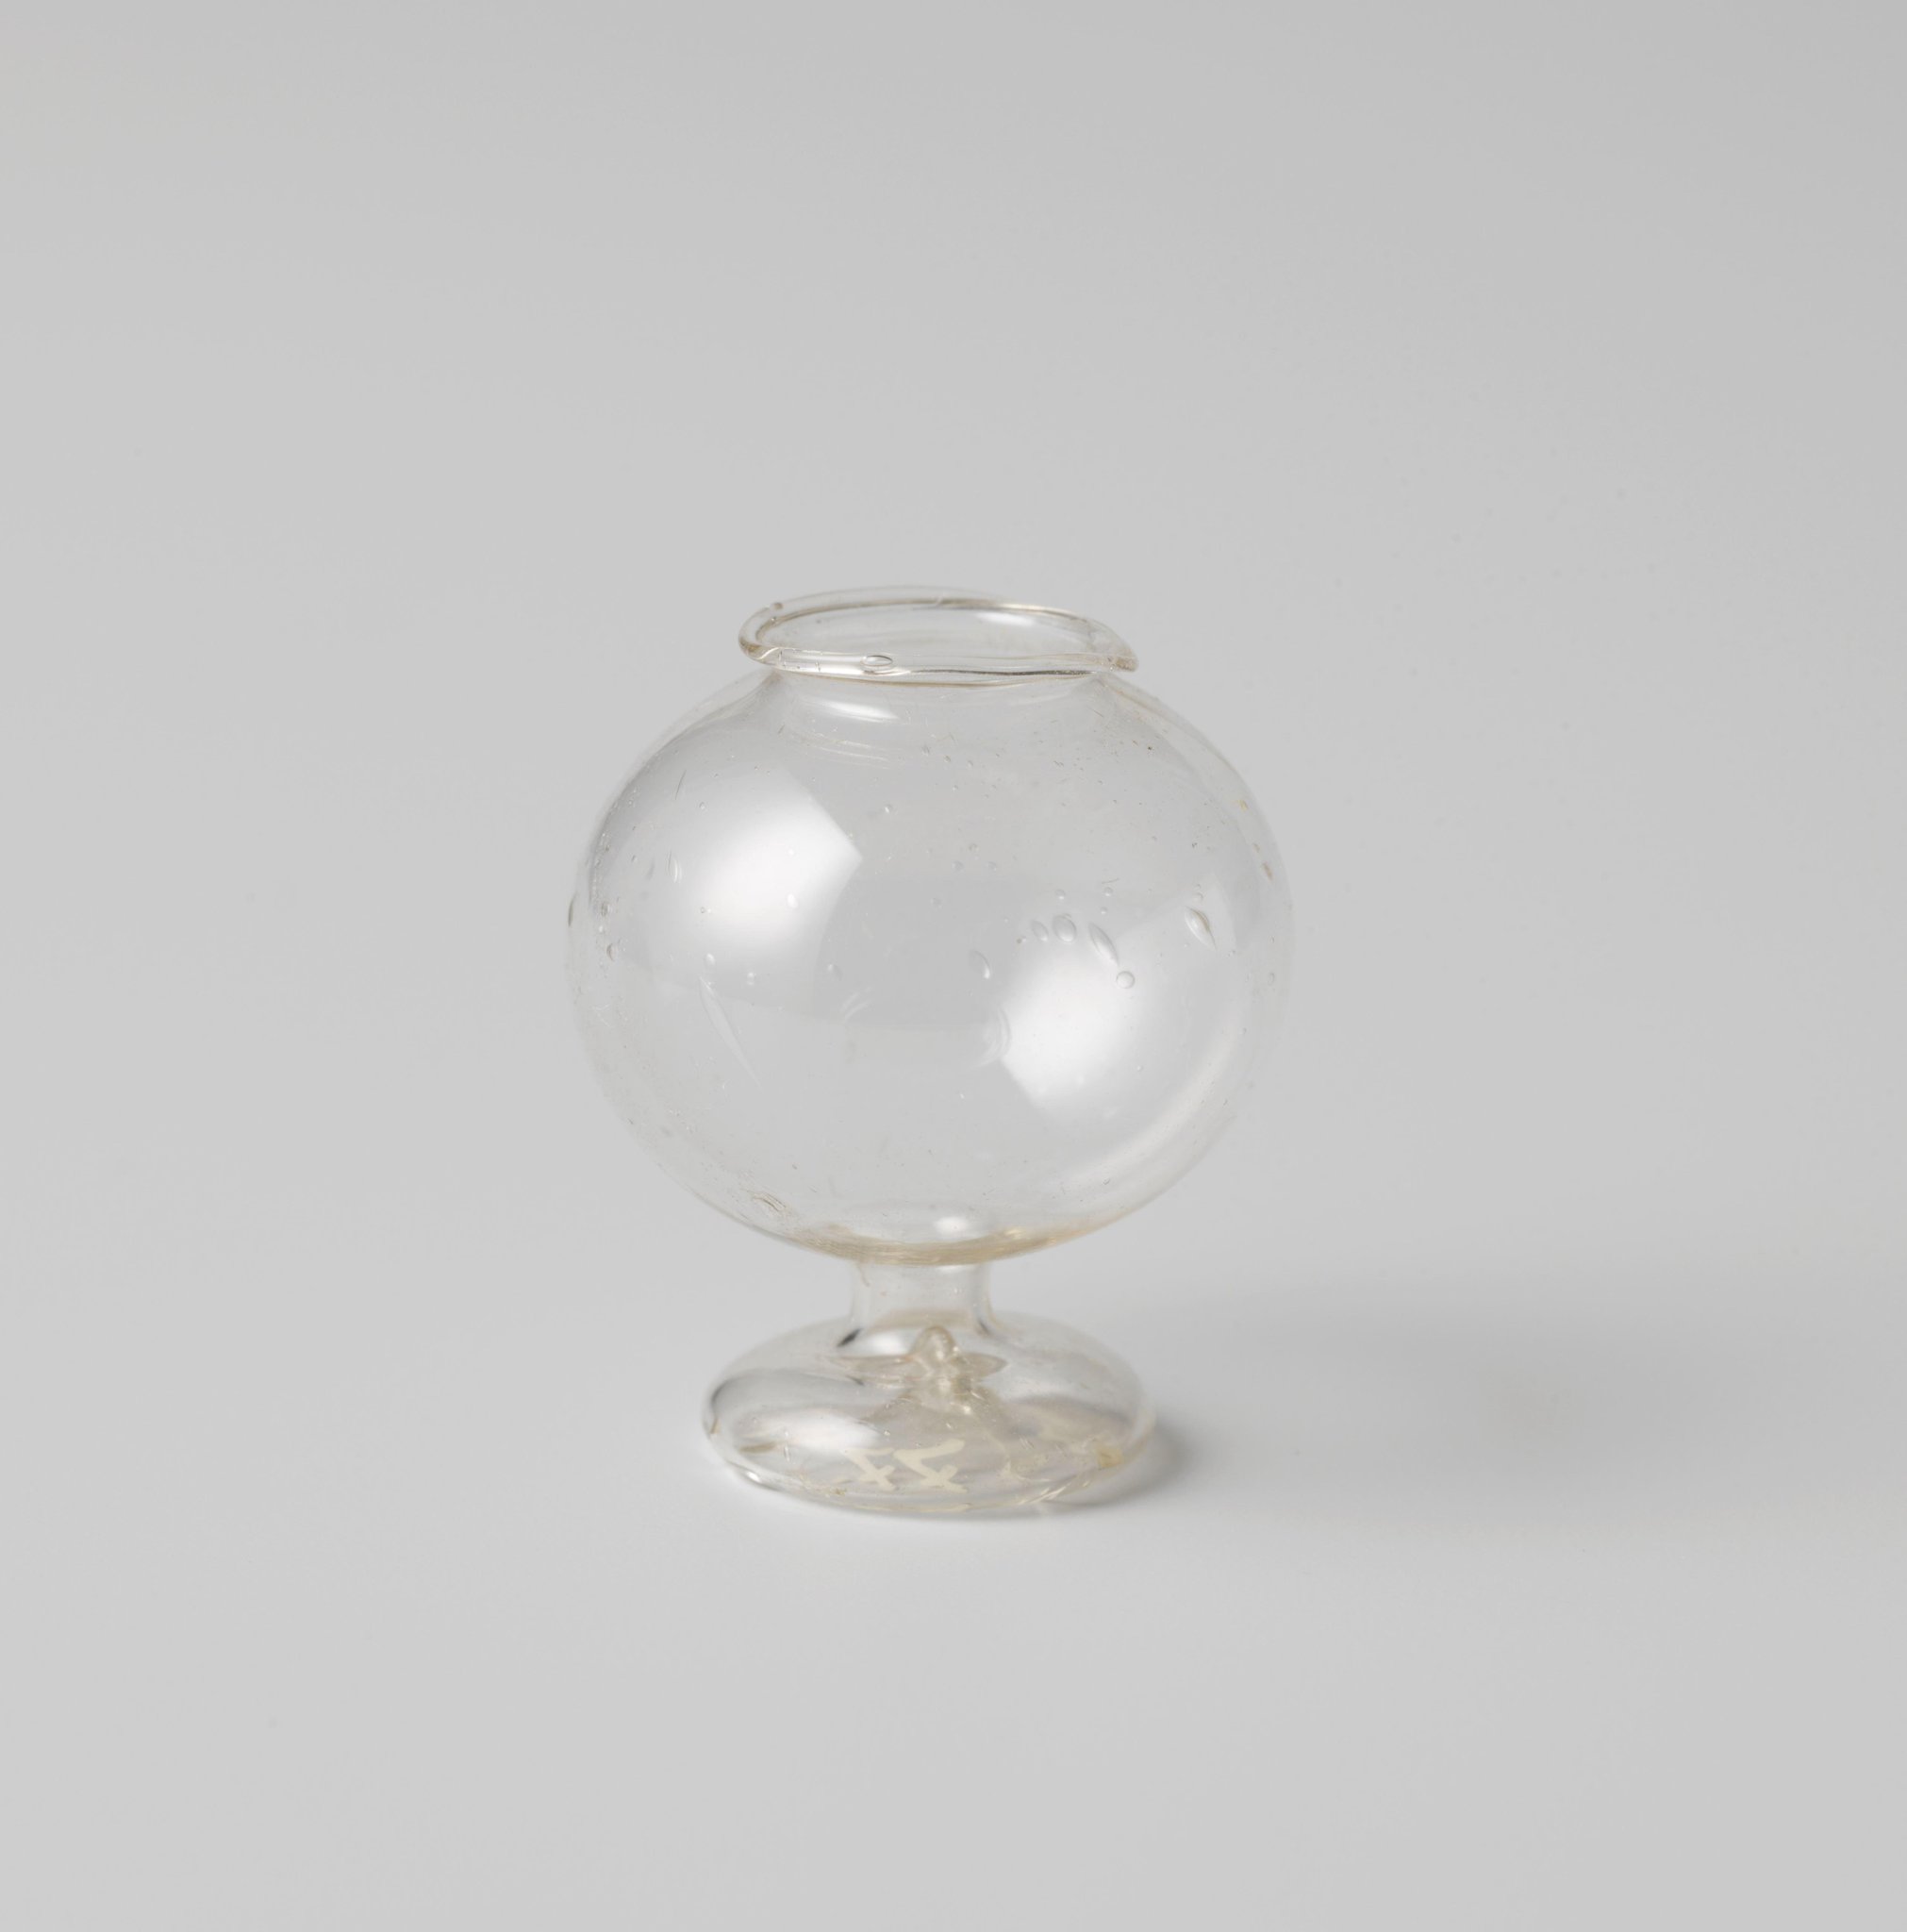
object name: miniature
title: Glas, mogelijk voorstellend een waterlens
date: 1675-1699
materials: glass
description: Glas, helder kleurloos, mogelijk voorstellend een waterlens; grote bolle cuppa met nauwe naar buiten omgeslagen rand, op naar binnen gestoken holle voet en op korte stam.